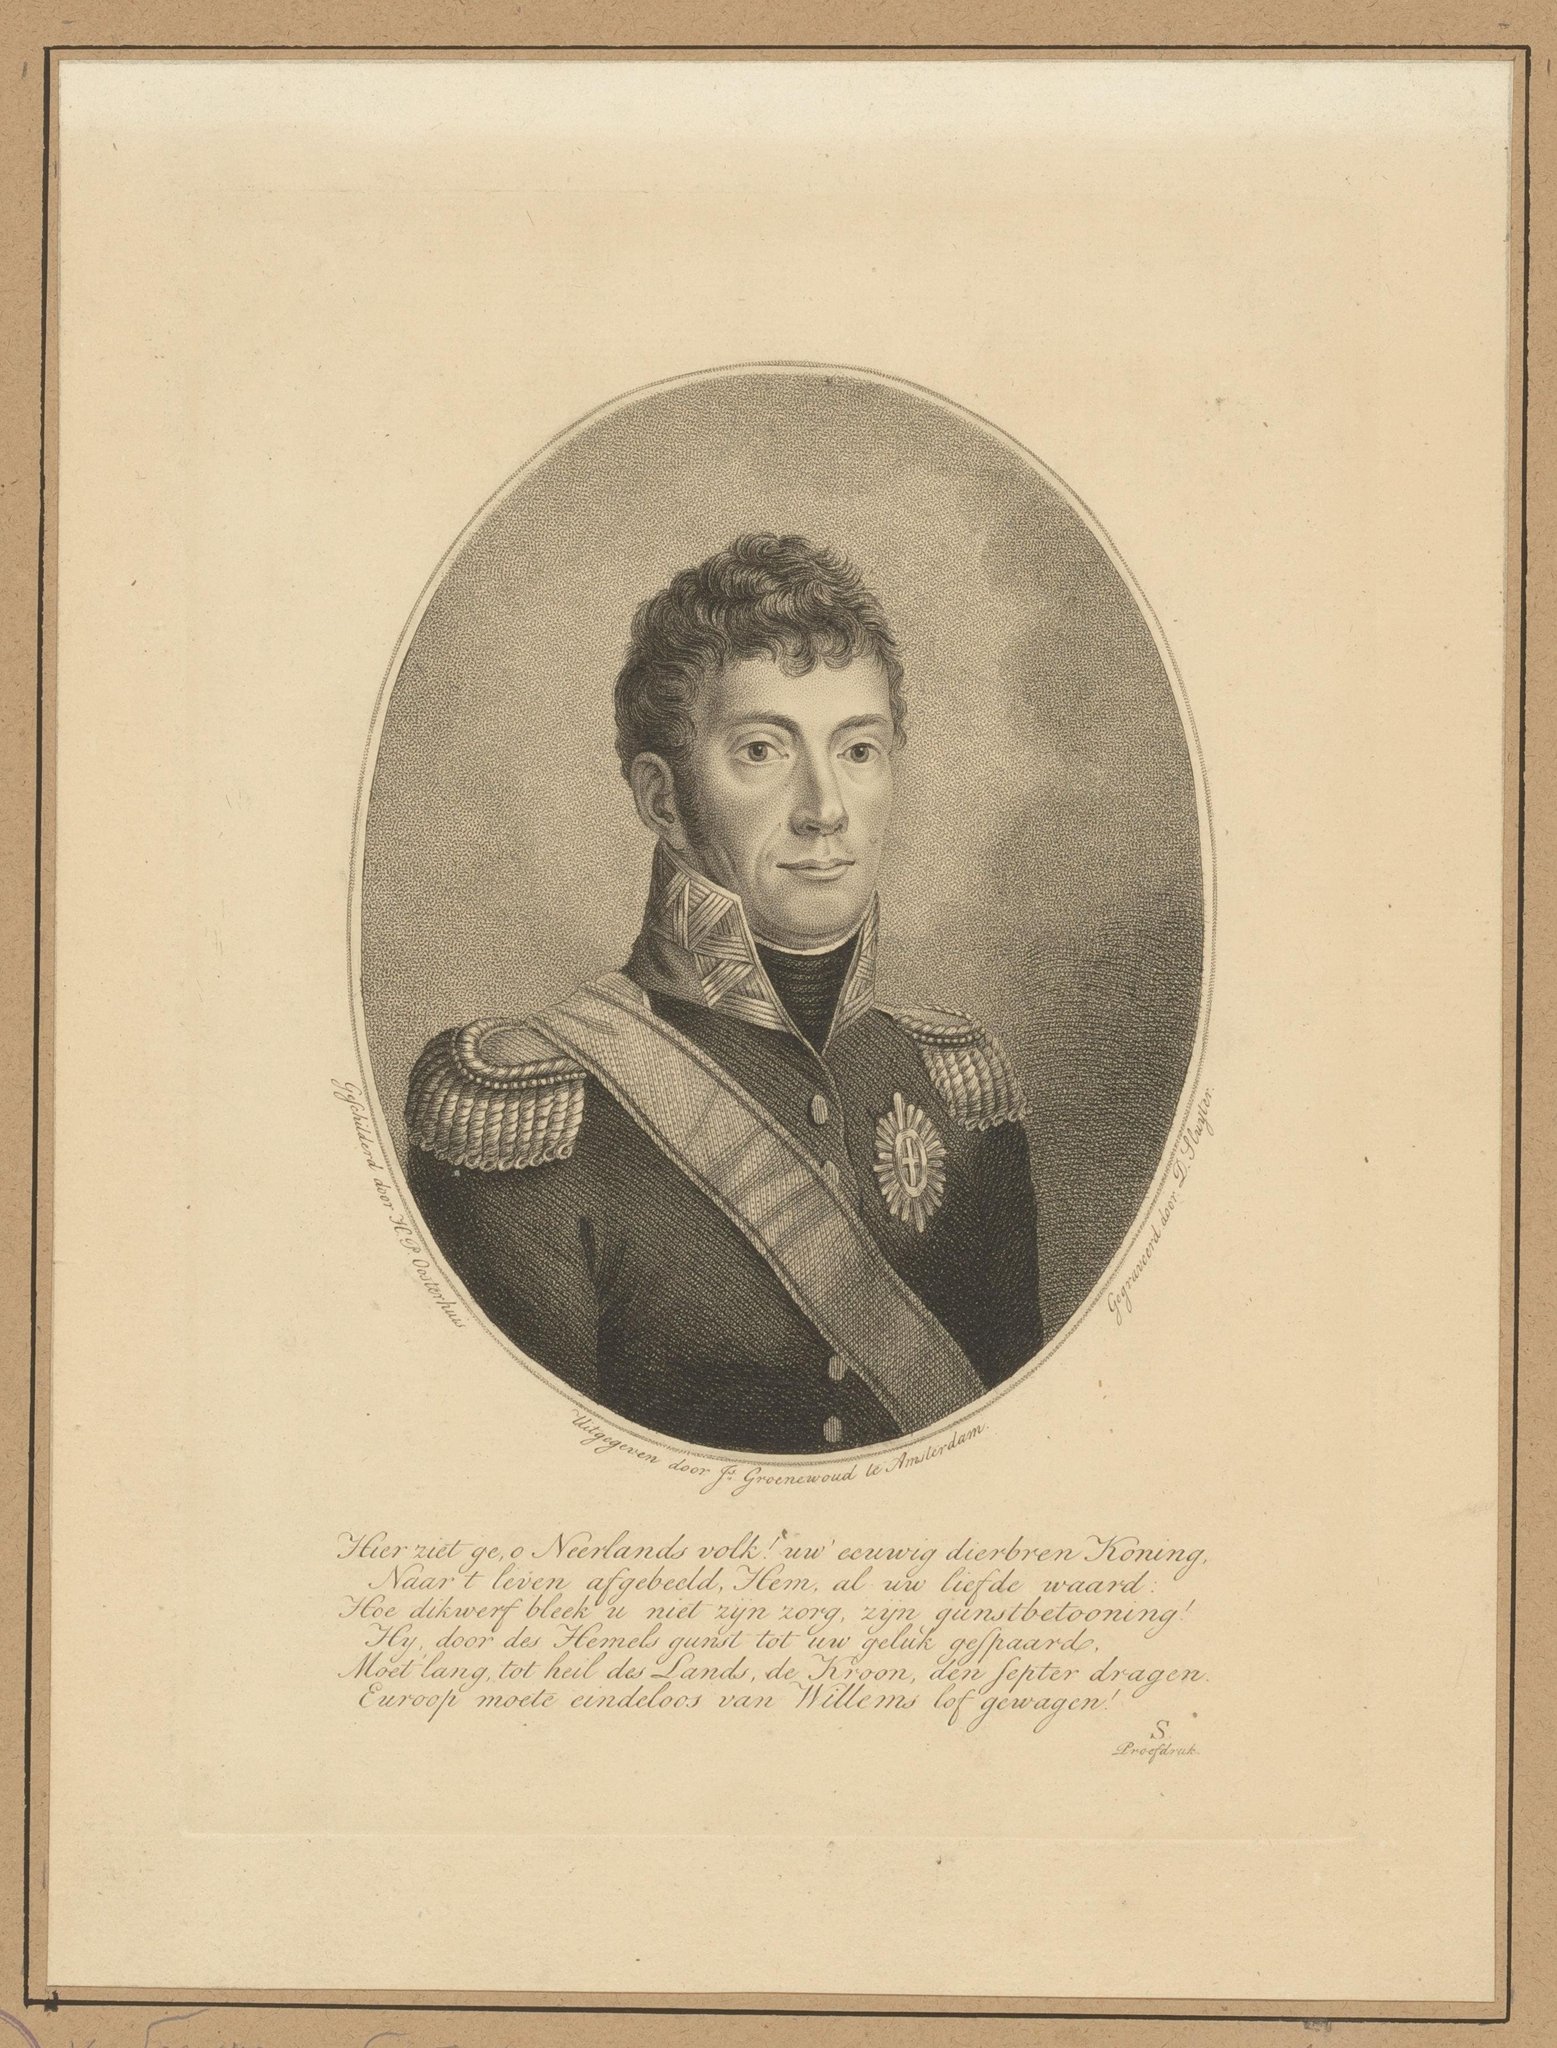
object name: print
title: Portret van Willem I Frederik, koning der Nederlanden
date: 1815-1819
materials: paper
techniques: engraving, etching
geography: amsterdam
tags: the hague, berlin, william i of the netherlands, historical persons, king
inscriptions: collector's mark: Lugt 1641, stamp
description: Portret van Willem I Frederik in een ovaal. In de ondermarge zes regels Nederlandse tekst. Onderwerpsrubrieken binnen de Atlas Zeden en Gewoonten: Portretten, Portretten van Vorsten uit het huis van Oranje, Regeerende Vorsten, Koningen uit het huis van Oranje.